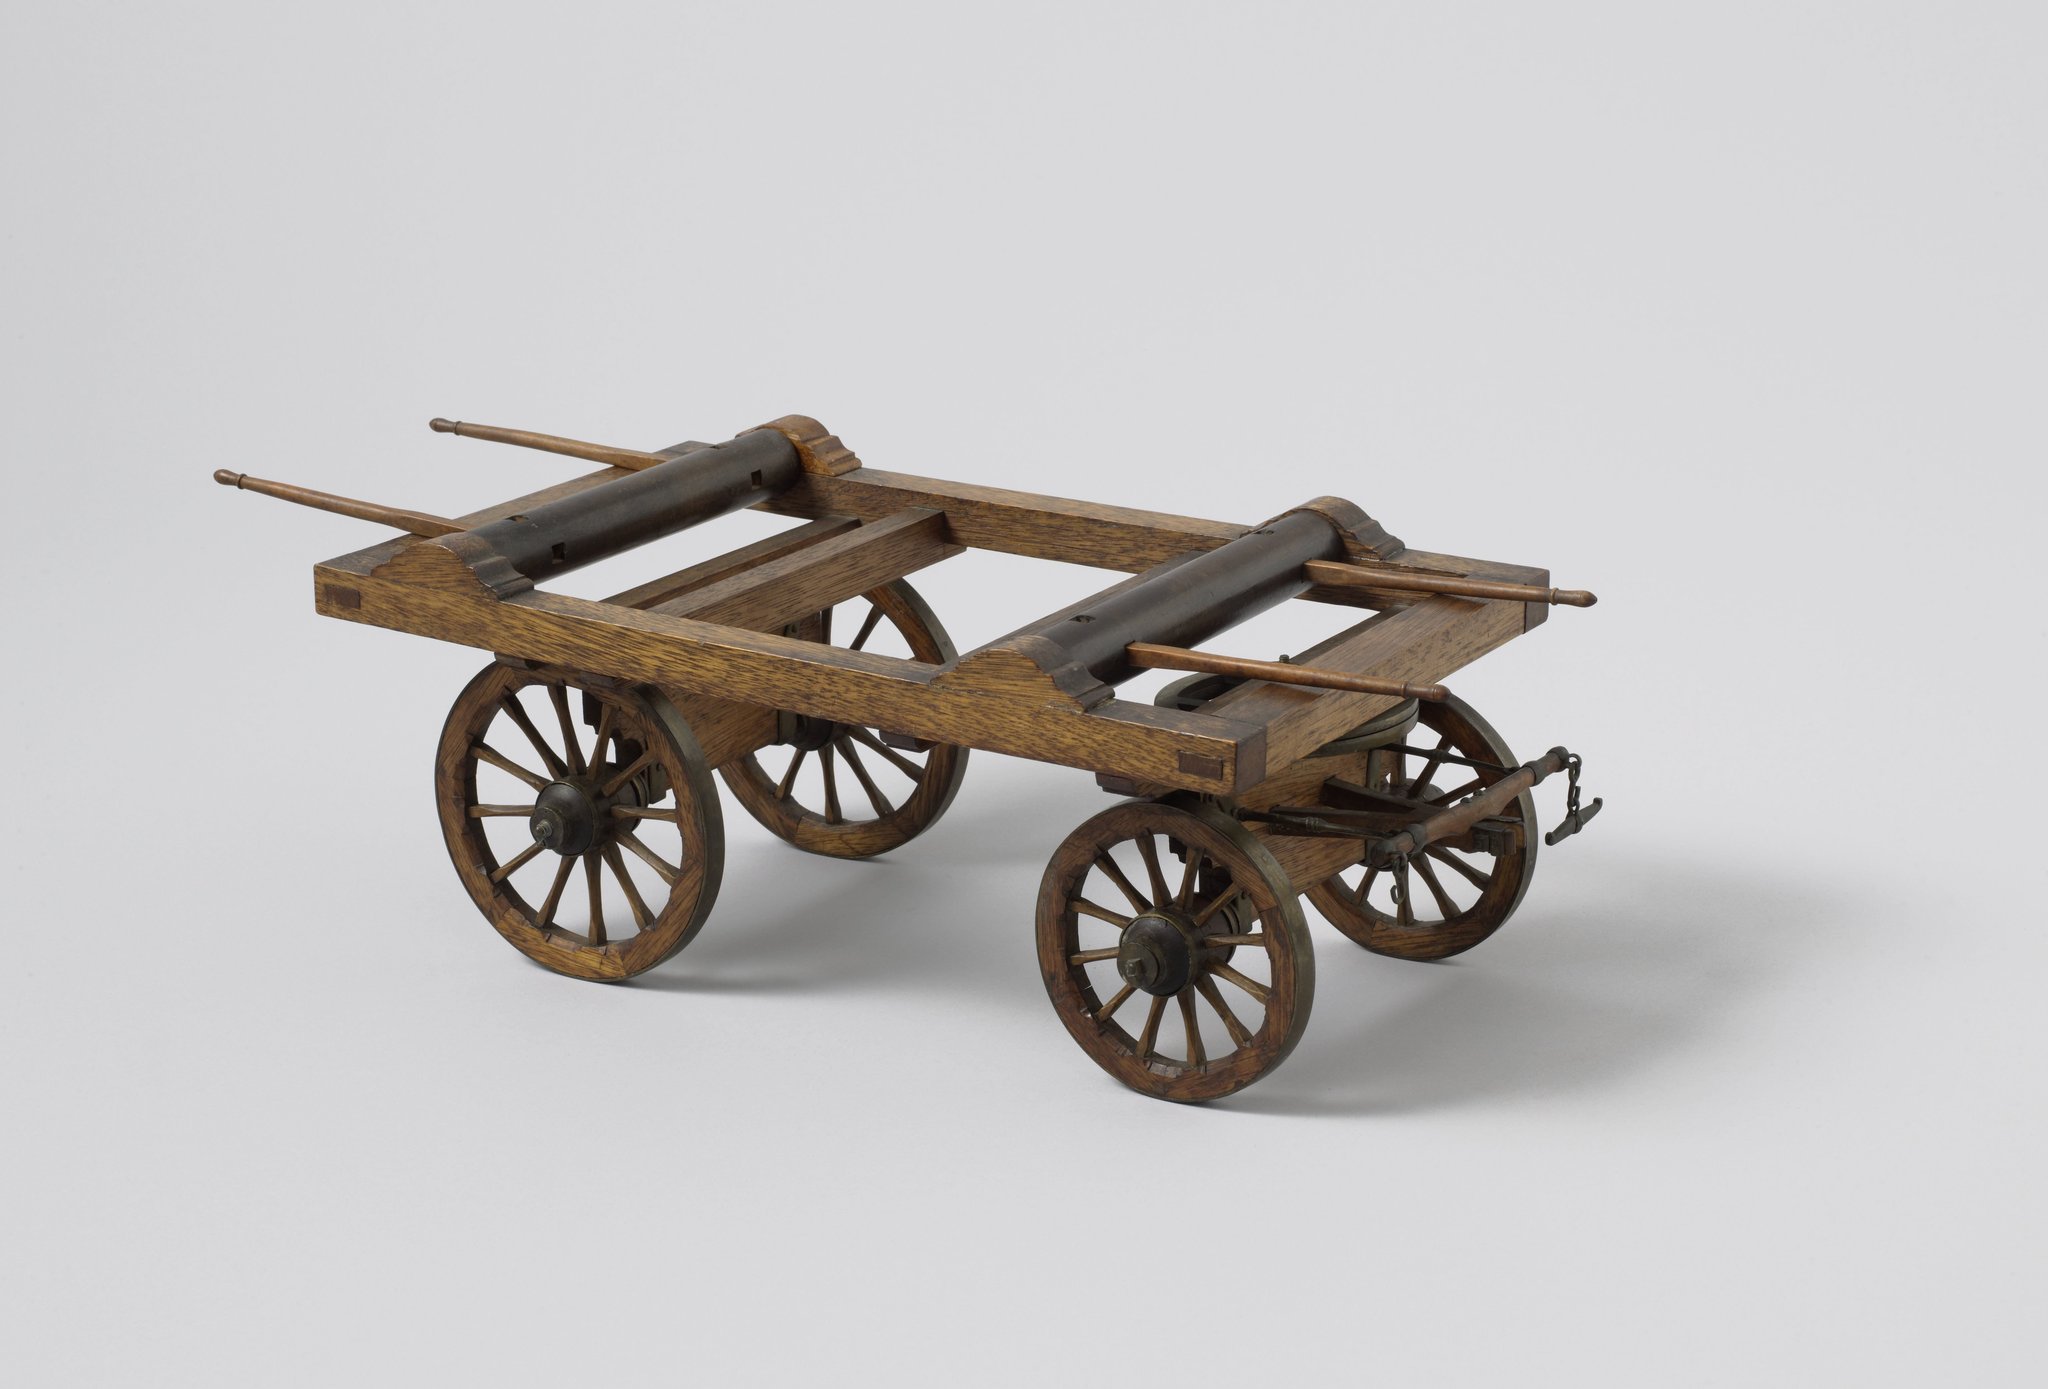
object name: demonstration model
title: Model of a Cart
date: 1797-1801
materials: brass, wood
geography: france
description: J.P. Asmus zag dit type wagen op zijn reis naar Frankrijk in 1797; het werd gebruikt voor het transport van artillerie, ankers en andere zware lasten tussen Parijs en Versailles. Hij vernoemt het model als onderdeel van de modellenkamer van de Rijkswerf te Amsterdam in 1801.